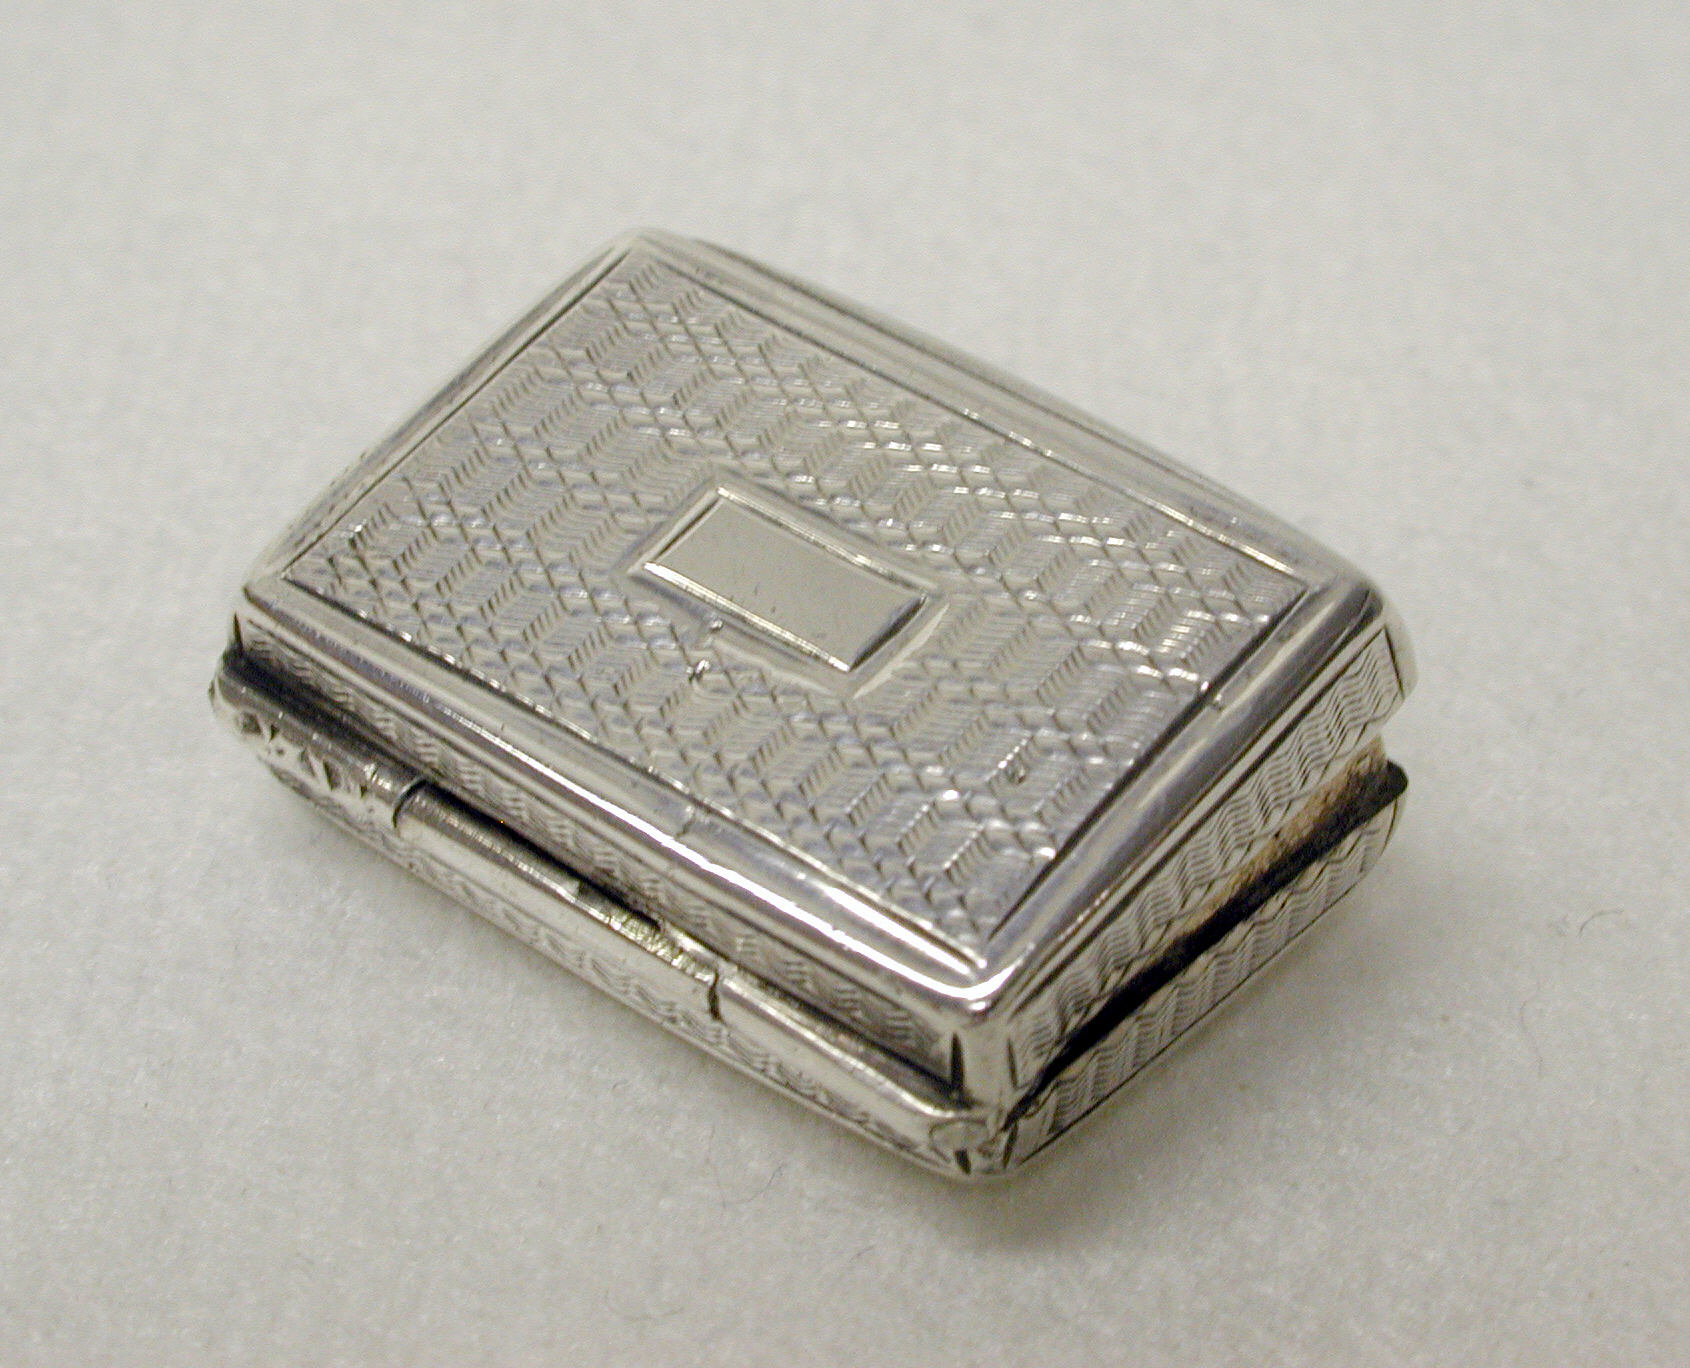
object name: vinaigrette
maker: john bettridge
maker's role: maker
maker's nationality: british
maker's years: 1817-1835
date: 1830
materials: silver